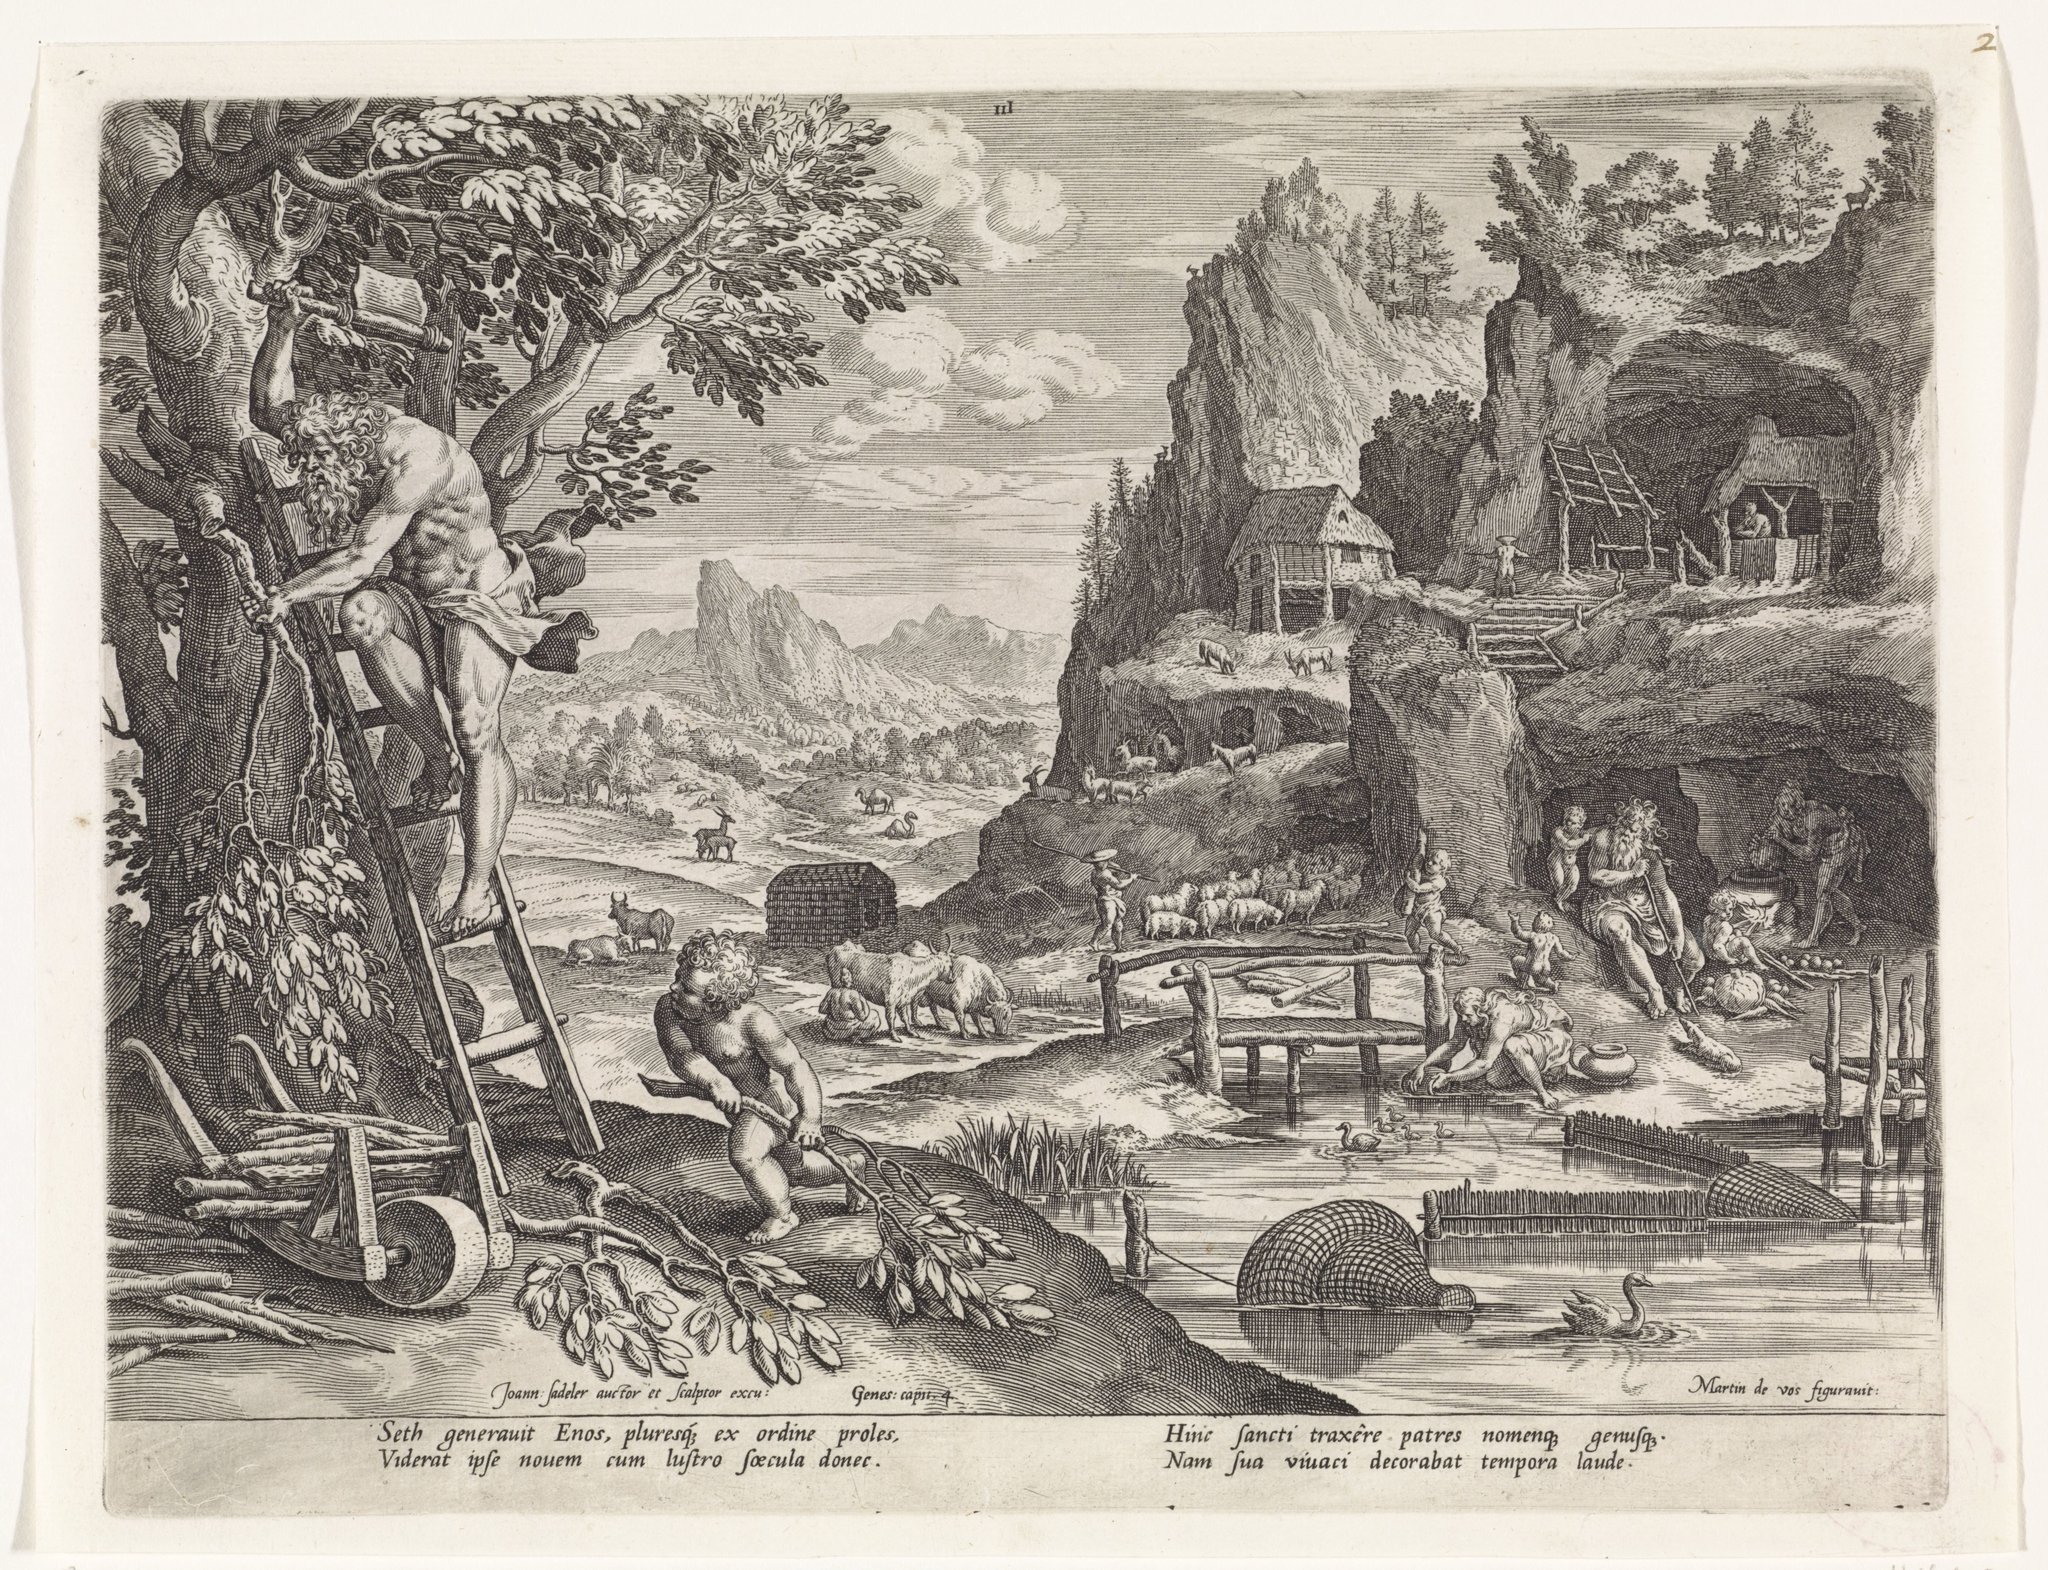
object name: print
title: Bonorum et Malorum consensio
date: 1586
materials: paper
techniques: engraving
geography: antwerp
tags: story of seth, story of enos, woodgathering, woodgatherer, woodcutting, woodcutter ~ forestry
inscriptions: collector's mark: Lugt 240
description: Set en zijn zoontje Enos zijn bomen aan het snoeien en hout aan het verzamelen. Links maakt de vrouw van Set het eten klaar terwijl de rest van de familie de dieren verzorgt. De prent heeft een Latijns onderschrift.